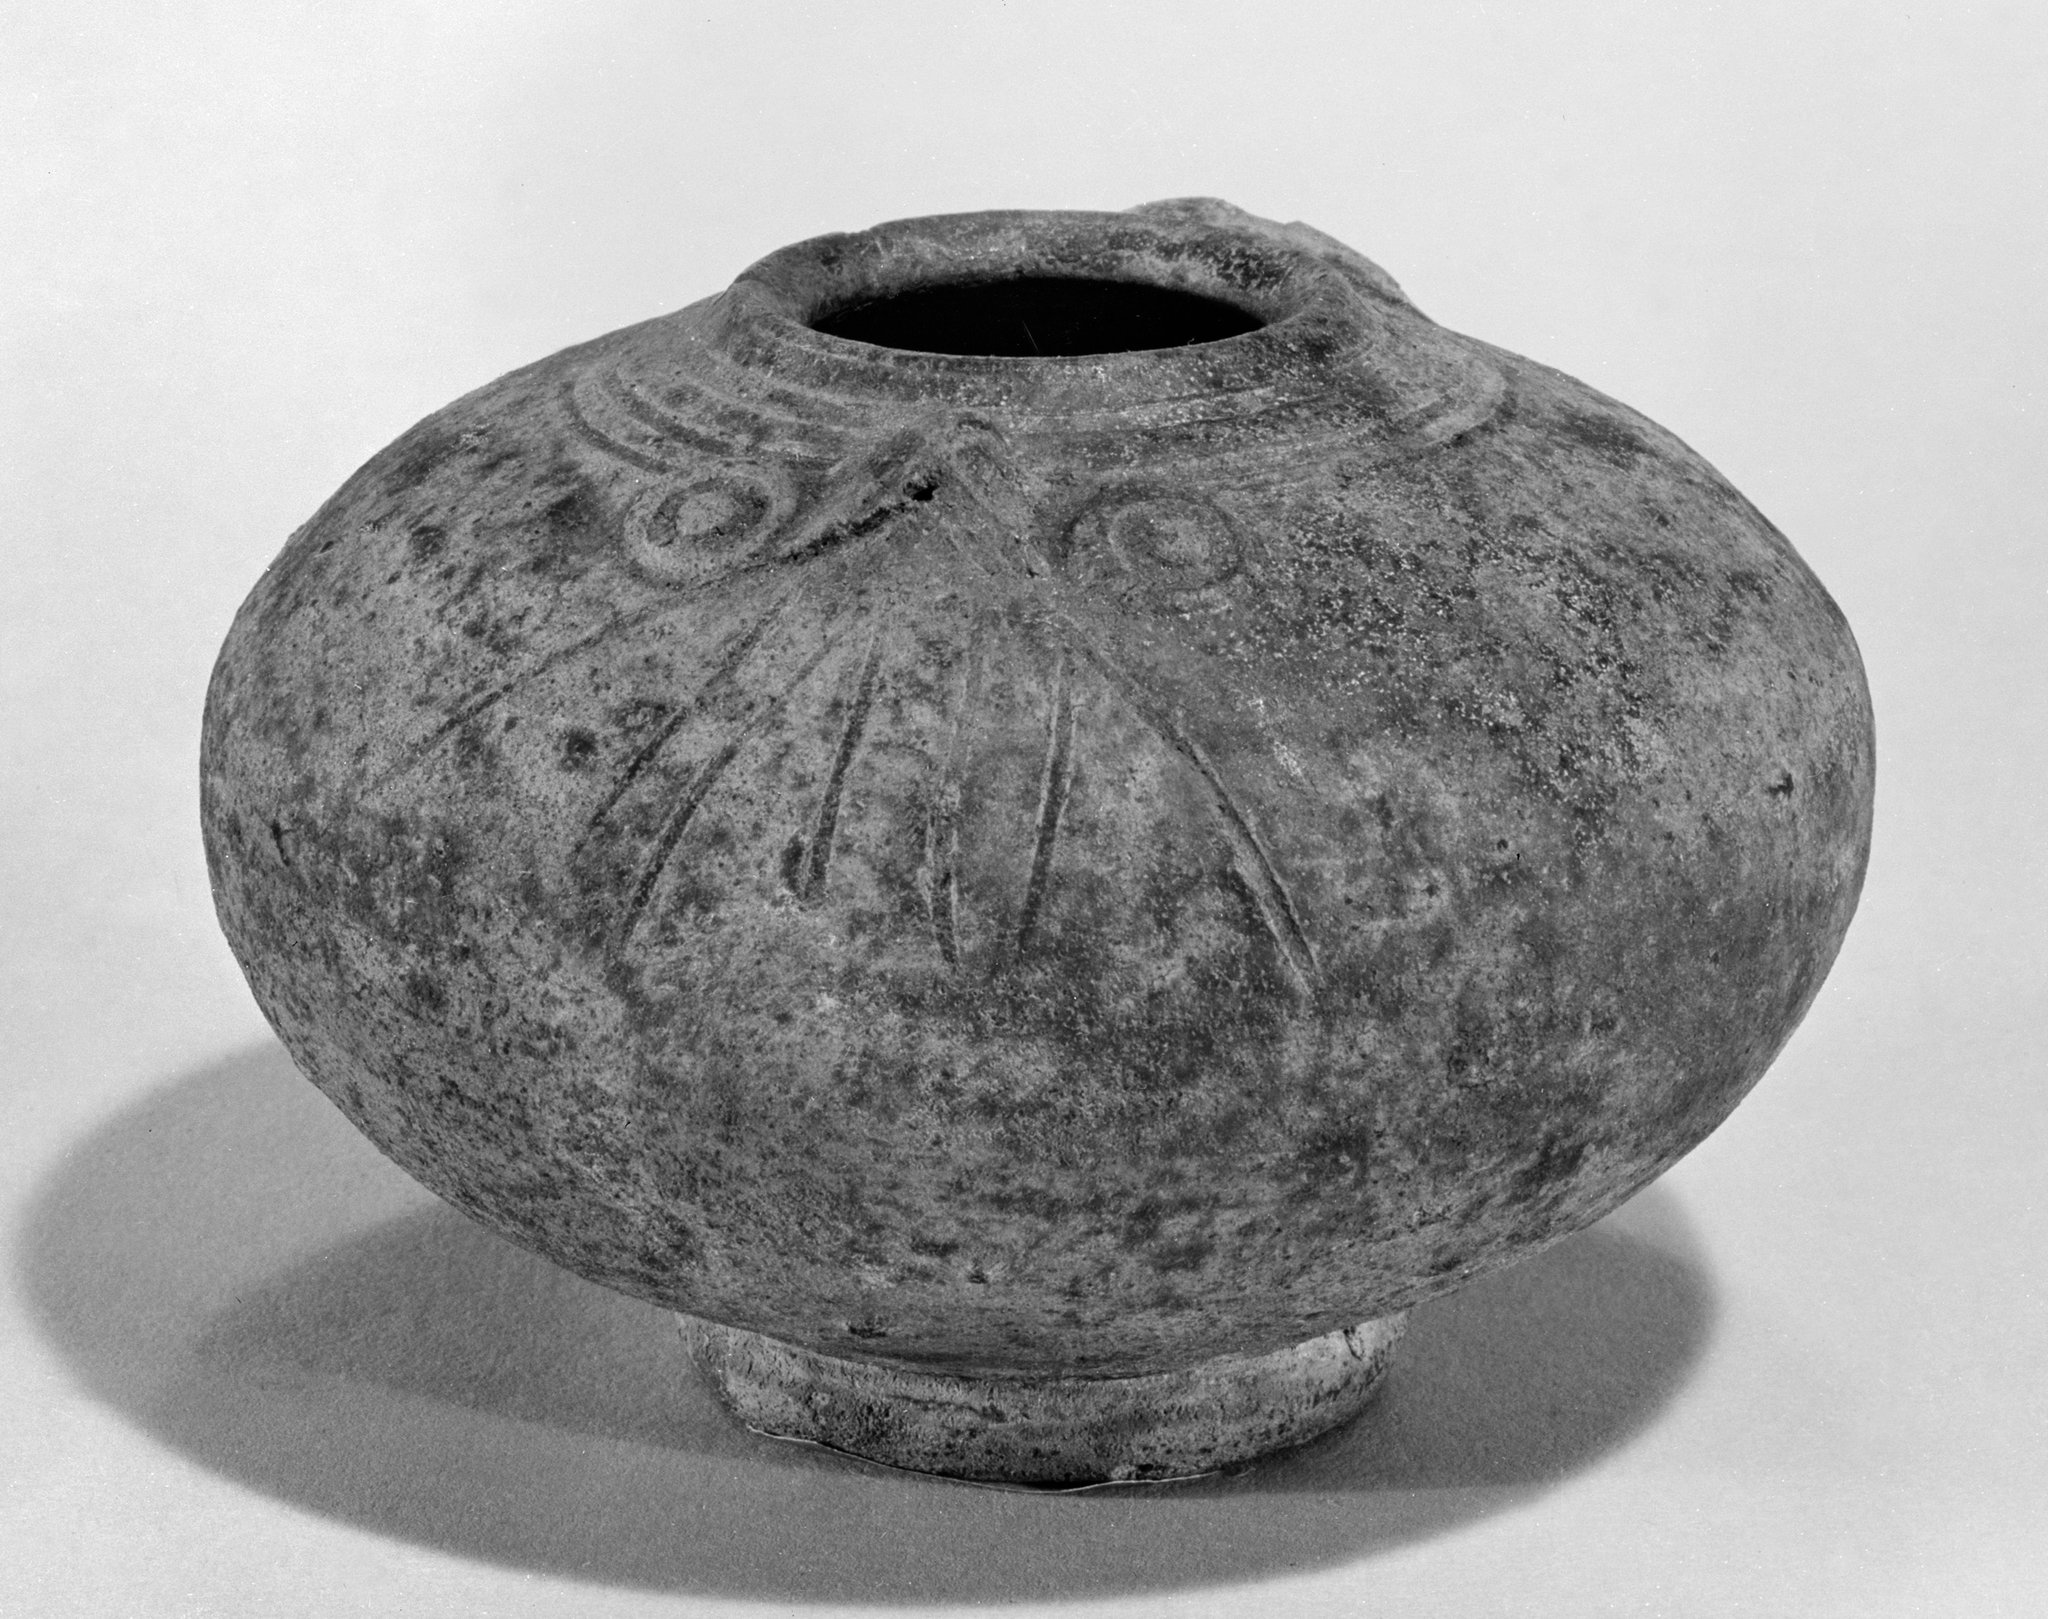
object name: pot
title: Pot in the Form of a Bird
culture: thai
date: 901-1200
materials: stoneware